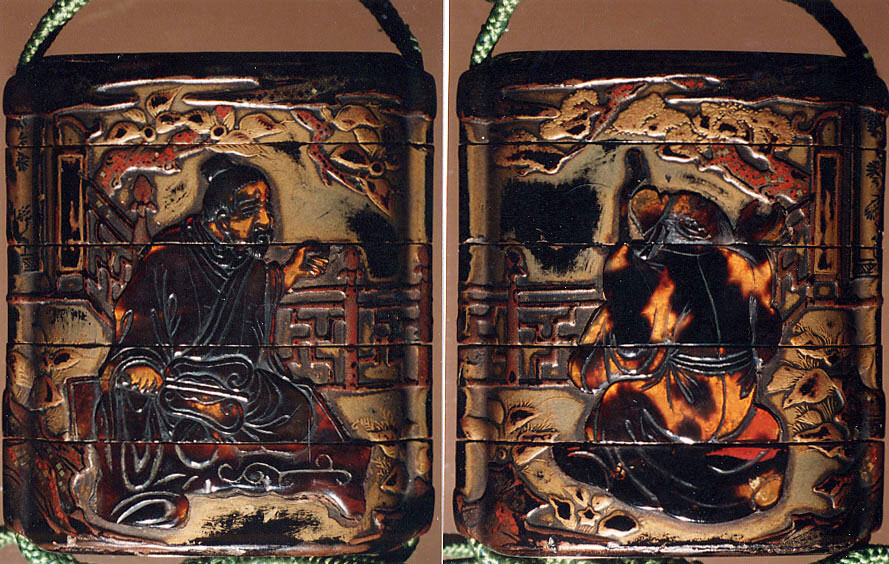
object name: inrō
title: Case (Inrō) with Design of Sages Seated on Verandah, One holding a Fan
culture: japanese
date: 1601-1800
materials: lacquer, shell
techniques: fundame, roiro, maki-e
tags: fans,men